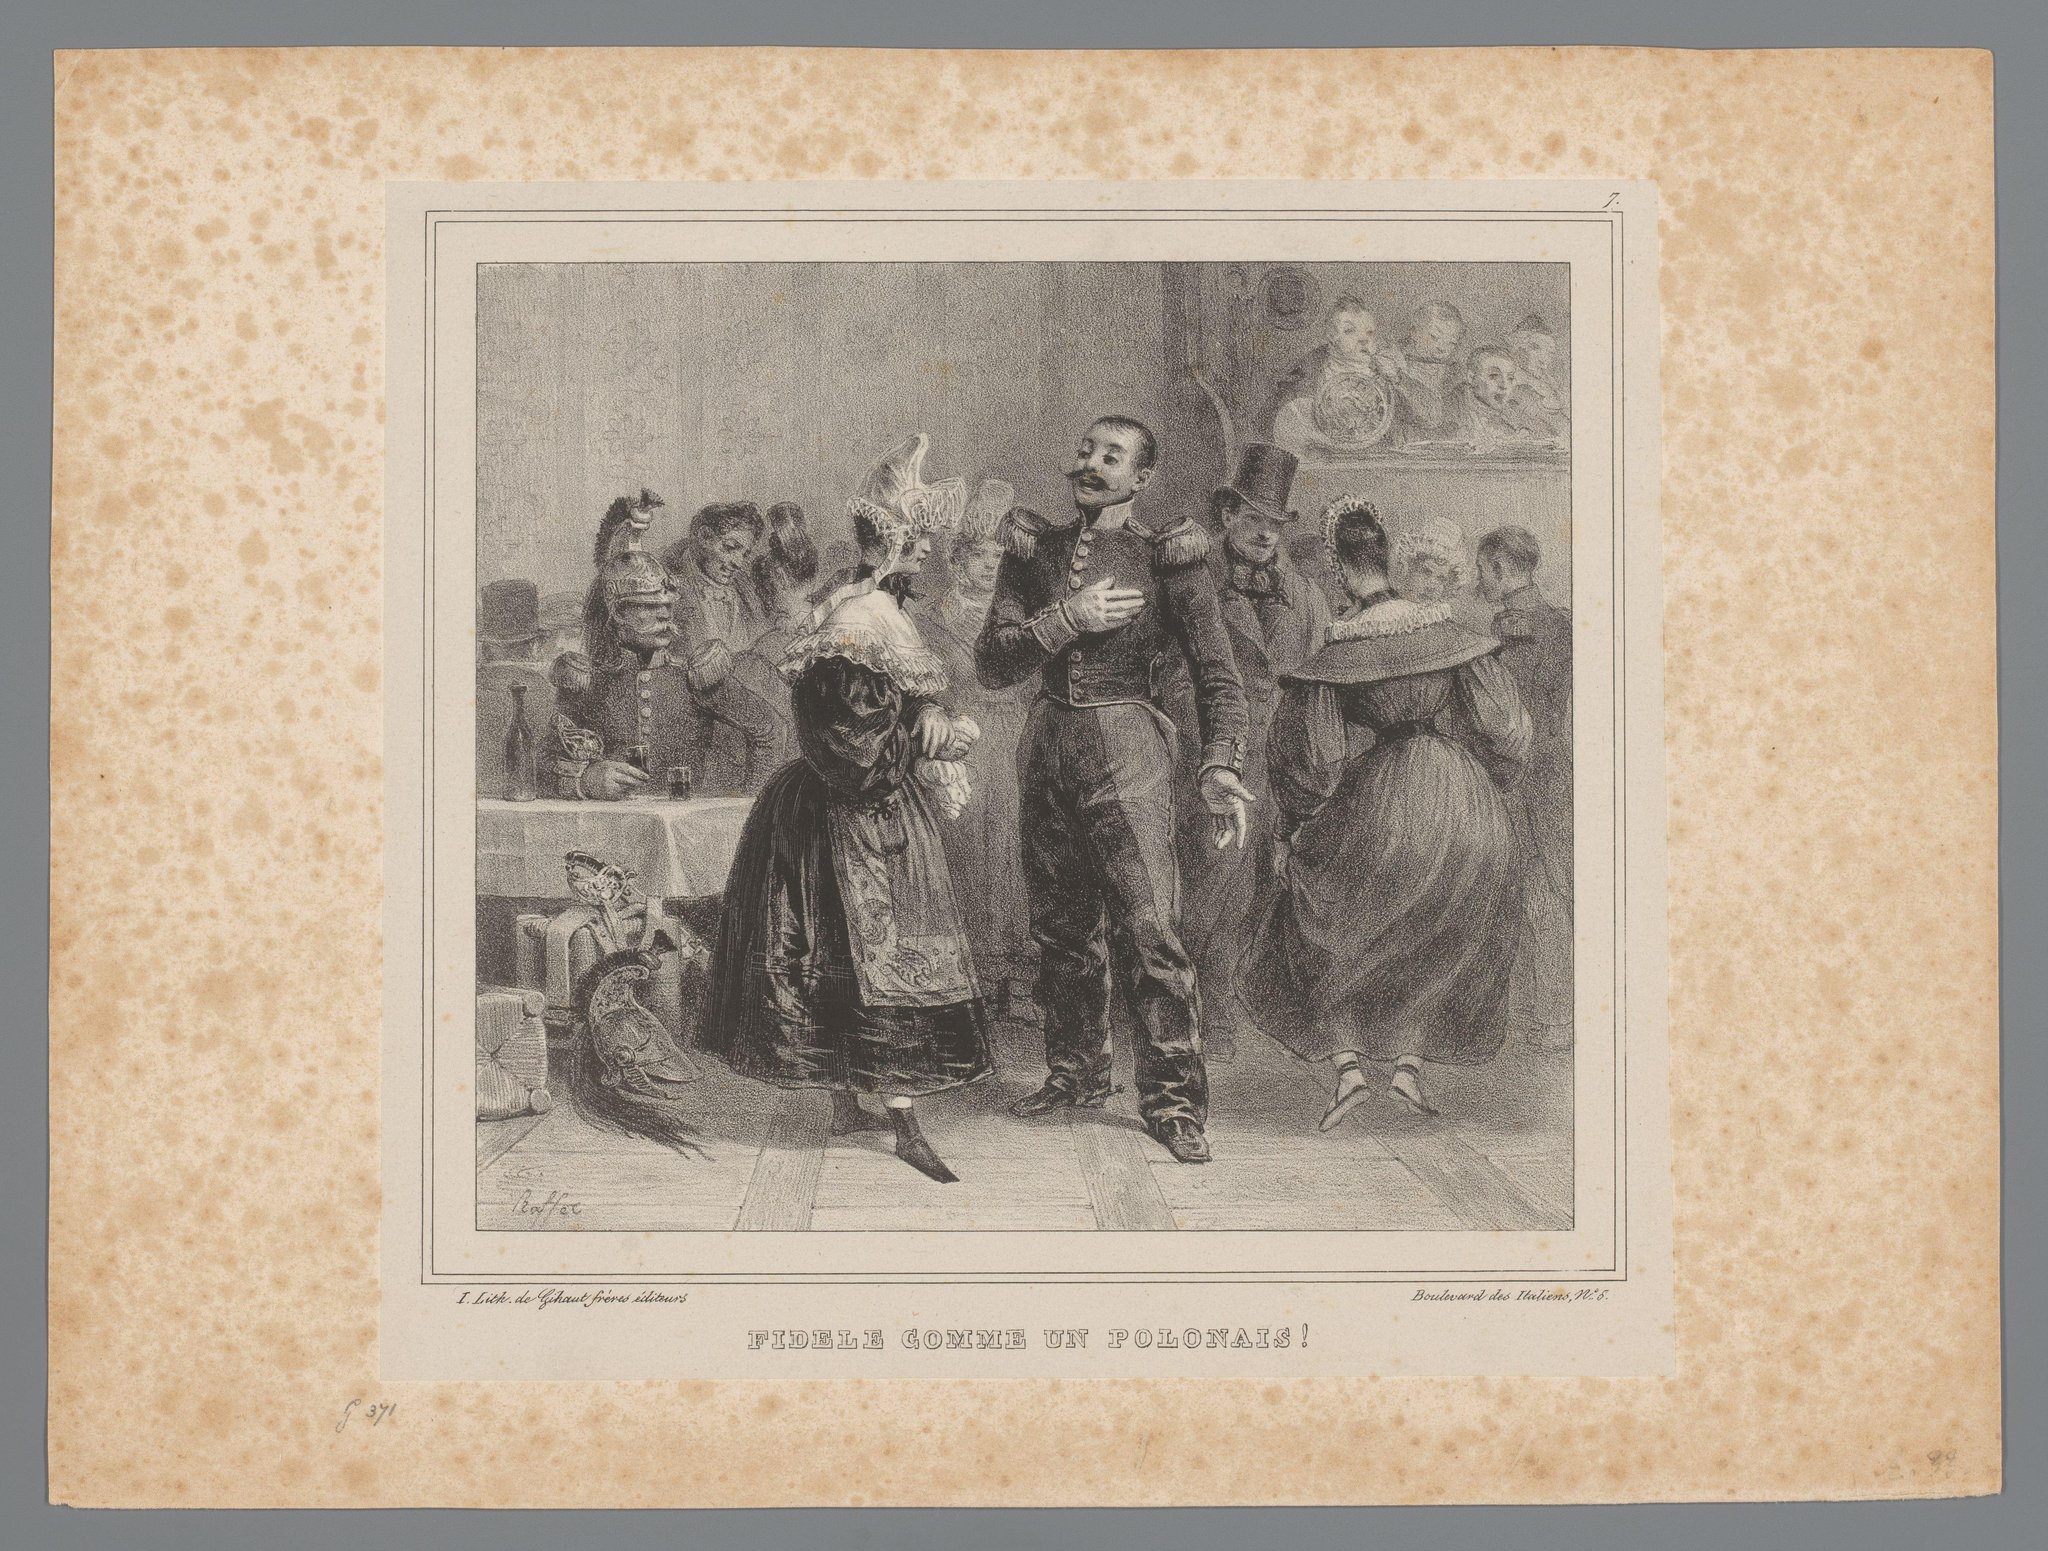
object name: print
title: Man en vrouw tijdens een bal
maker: denis auguste marie raffet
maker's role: draughtsman, print maker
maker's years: 1804-1860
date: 1833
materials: paper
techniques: lithograph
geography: paris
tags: fashion, clothing, adult woman, ball, formal dance, adult man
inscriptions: collector's mark: Lugt 964